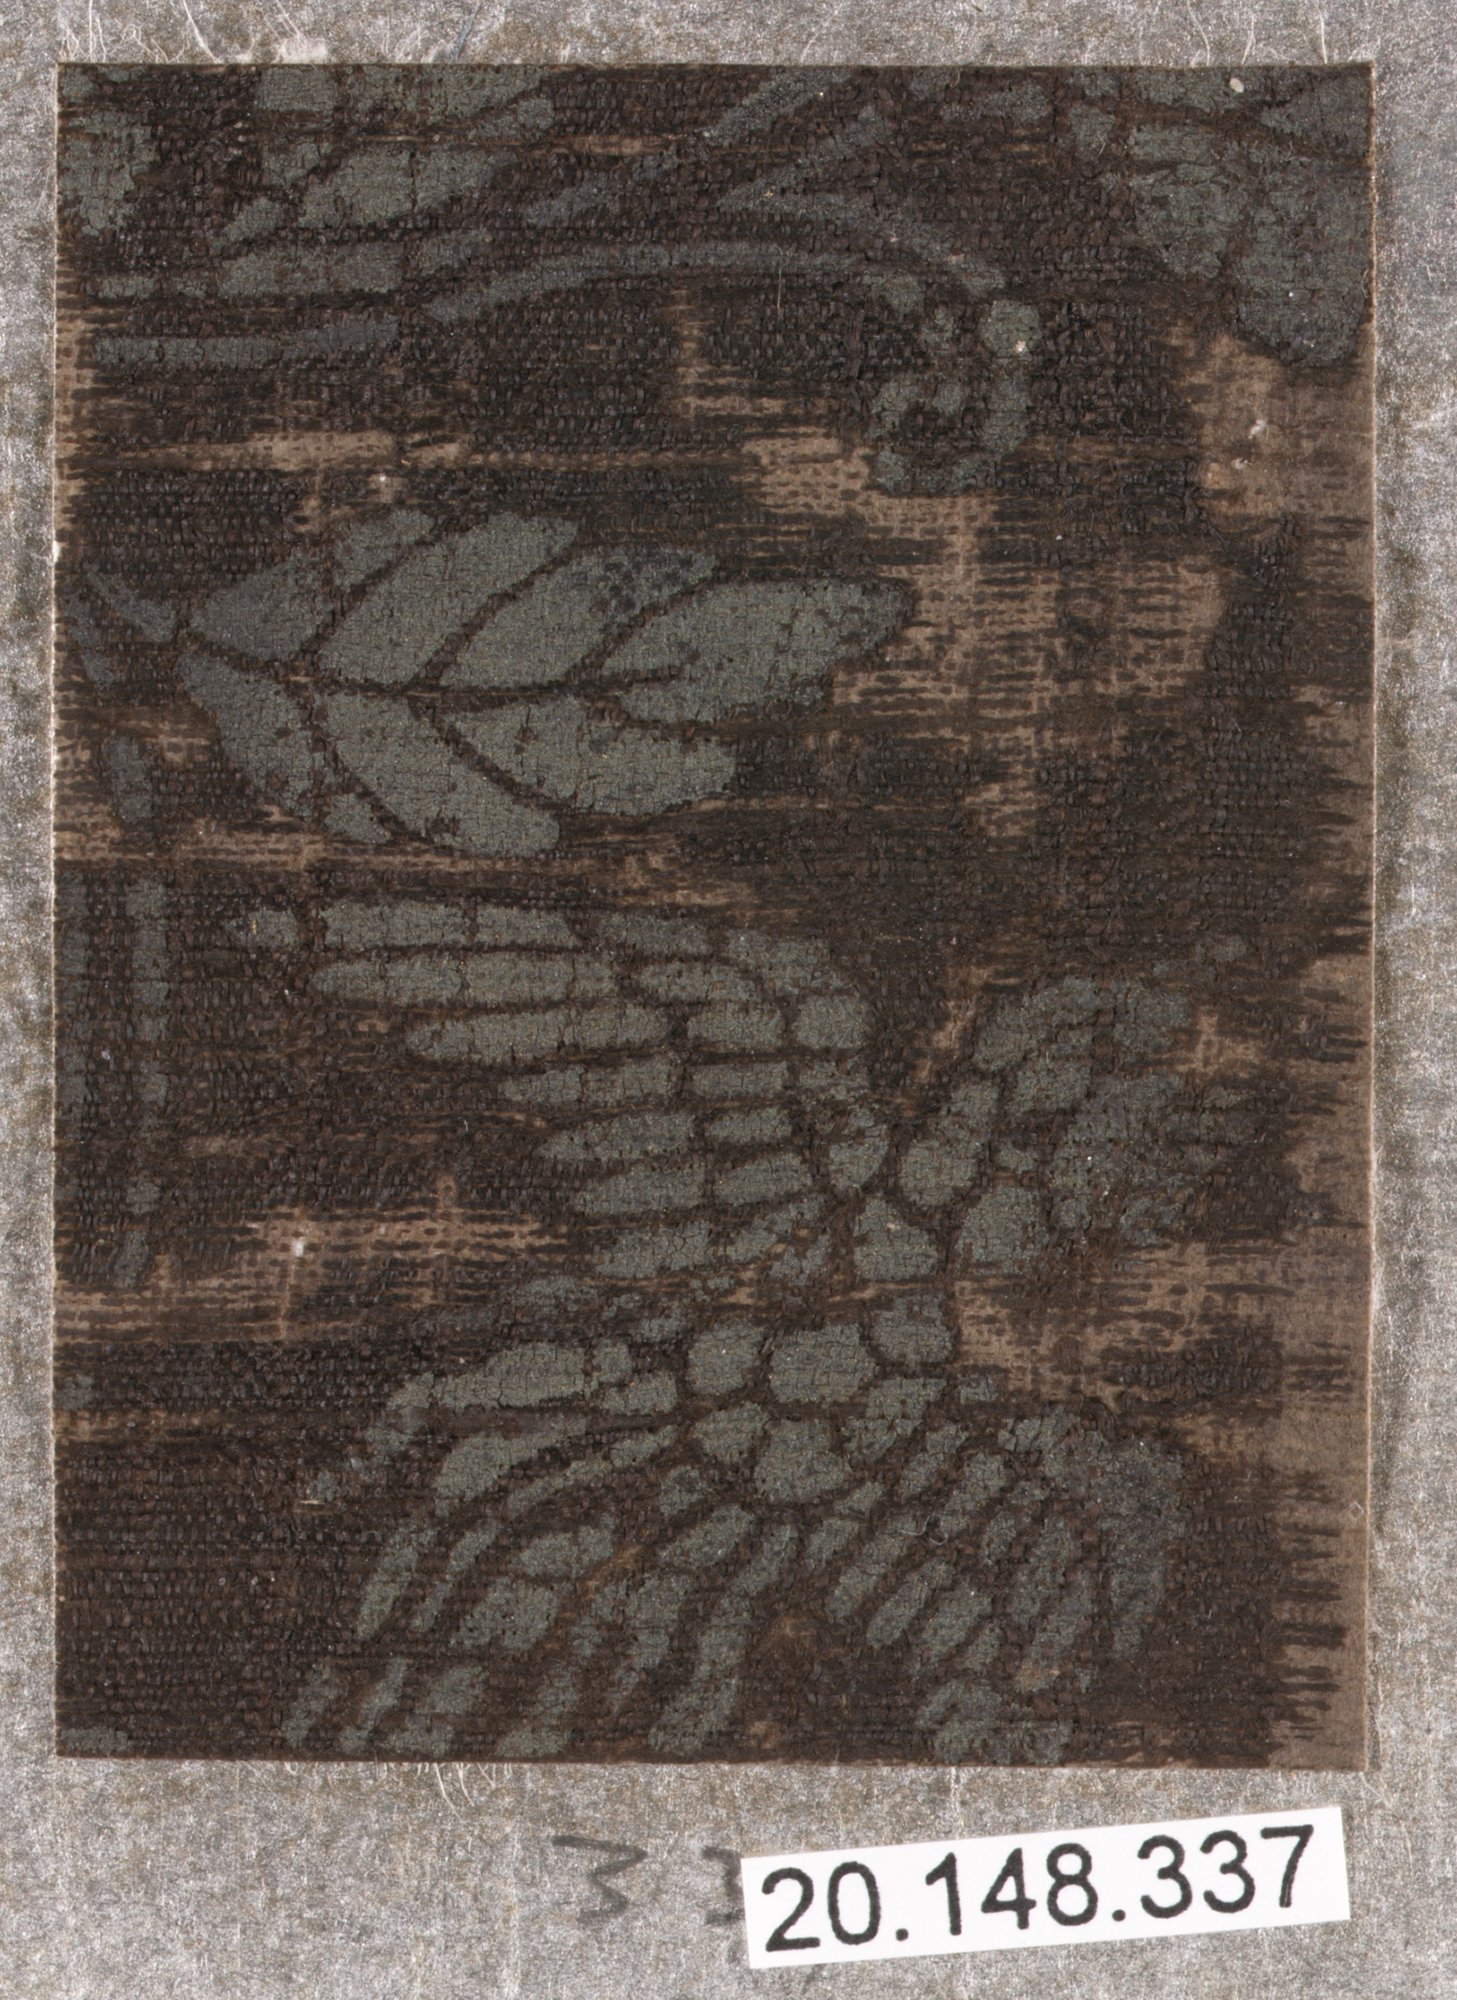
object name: piece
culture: japanese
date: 1601-1700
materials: silk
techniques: compound weave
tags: birds,leaves